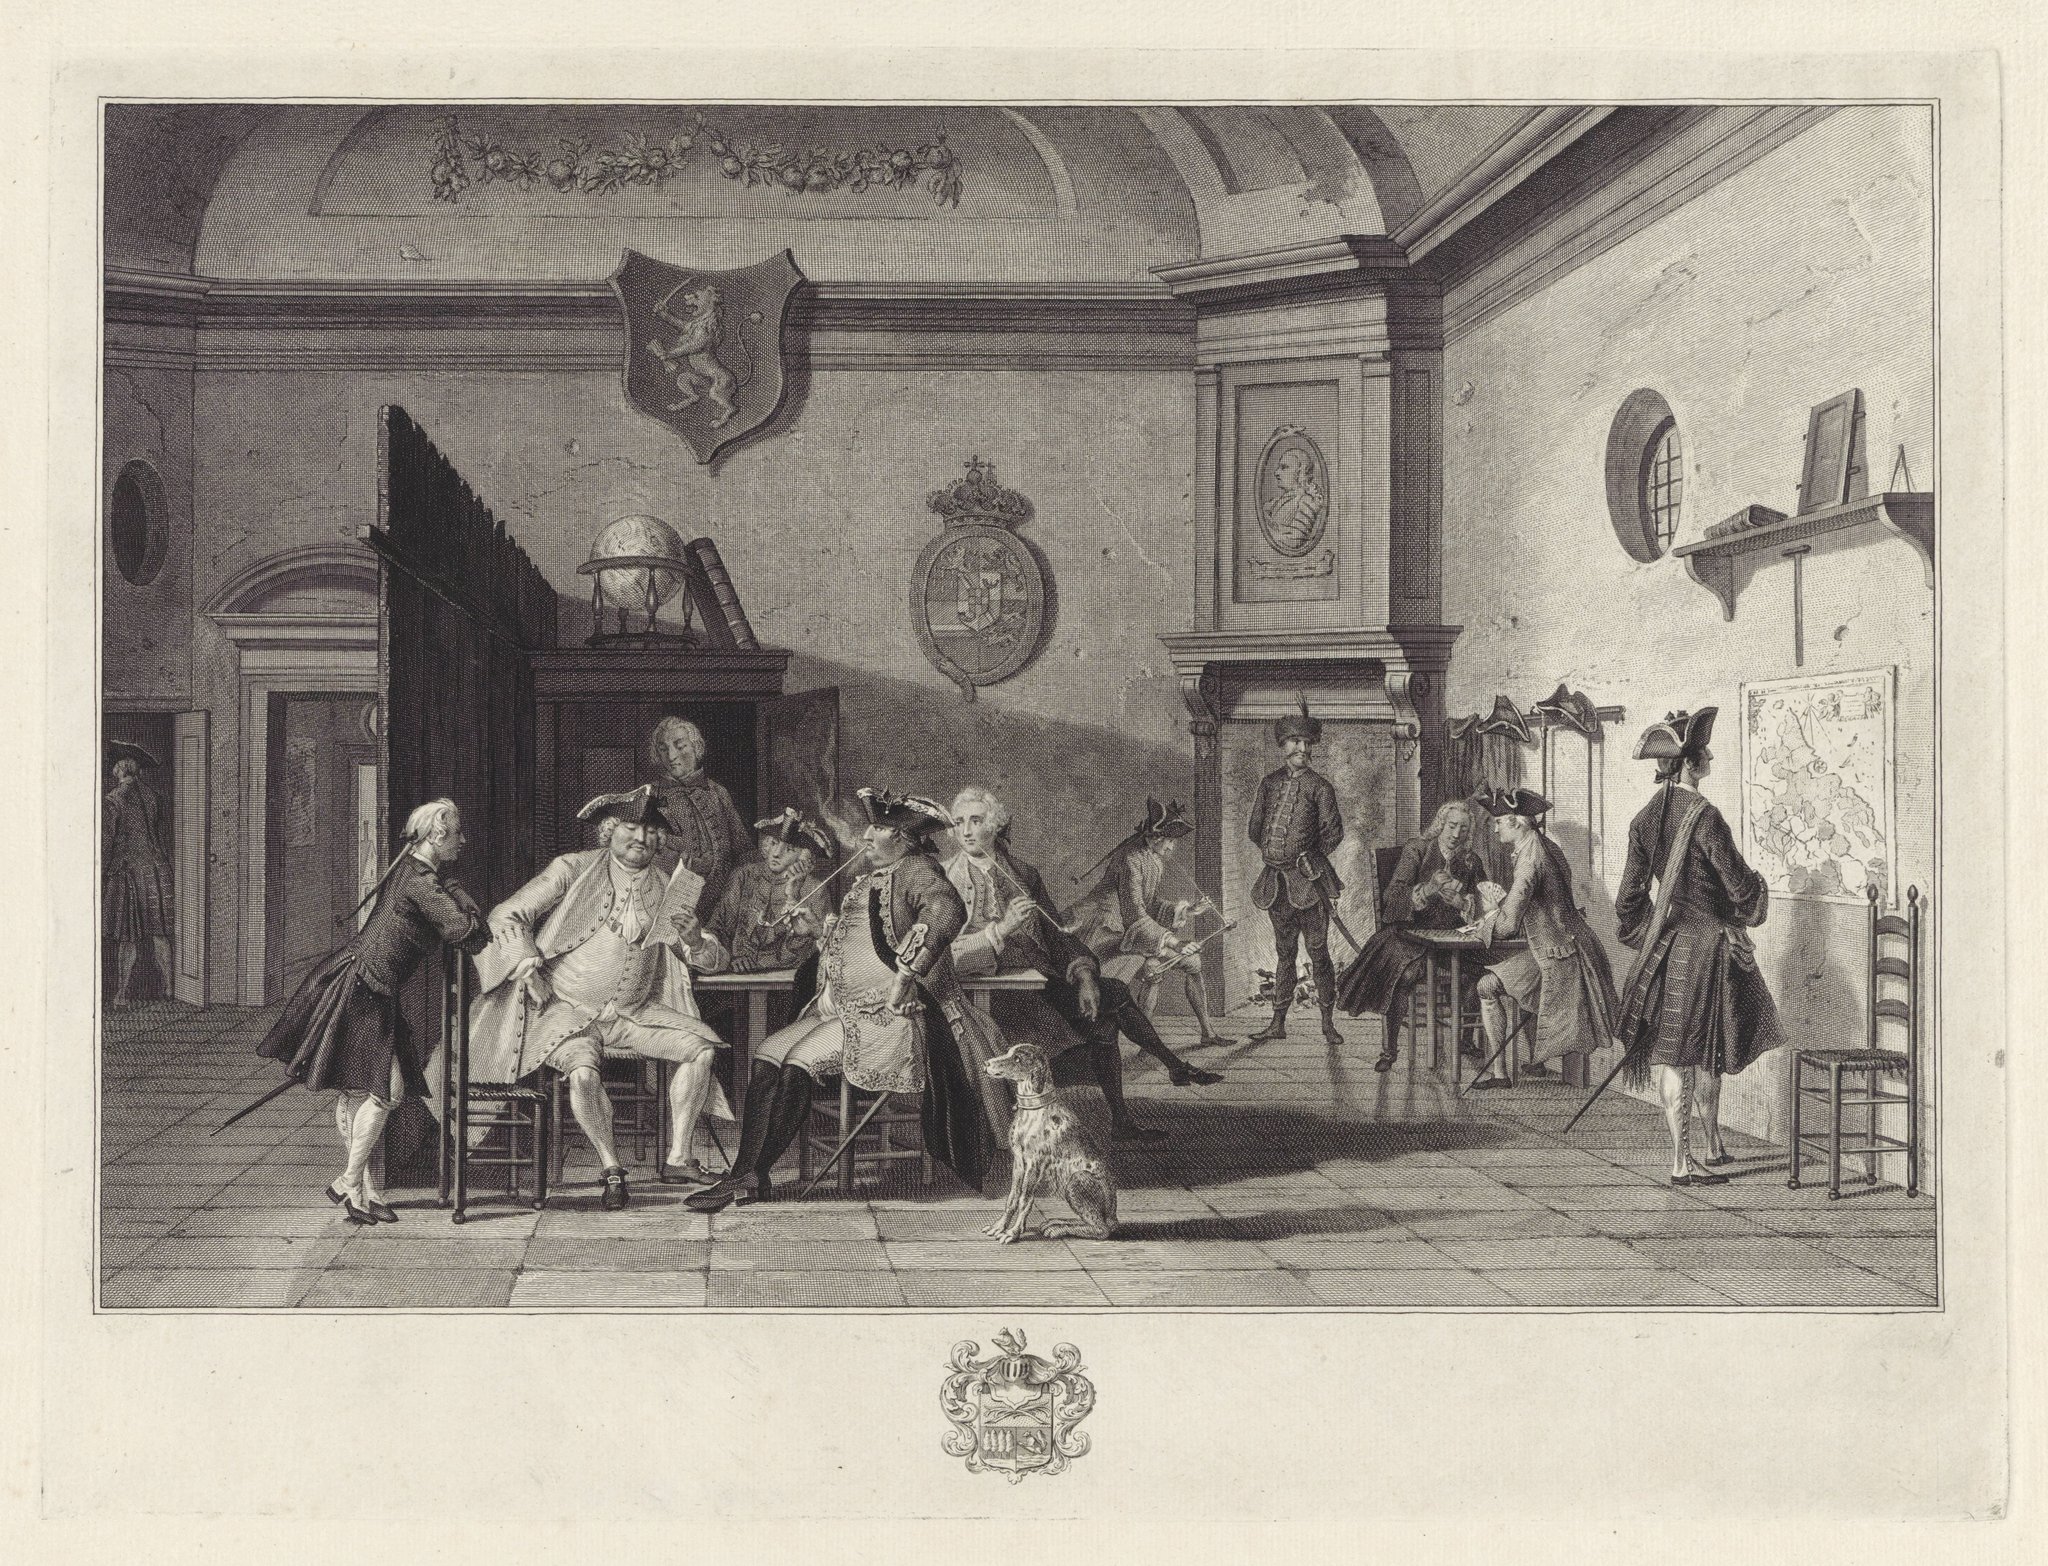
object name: print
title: Wachtlokaal met lezende, rokende en kaartspelende officieren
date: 1754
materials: paper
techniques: engraving, etching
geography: amsterdam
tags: maps of separate countries or regions, in the guard-room, 'kortegaard', officer, dog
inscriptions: collector's mark: Lugt 240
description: Wachtlokaal met lezende, rokende en kaartspelende officieren. Rechts bestudeert een van hen een kaart van de Nederlanden. Aan de muur een wapenschild met de Hollandse Leeuw. Onderaan in de marge het wapenschild van Gerrit Braamcamp, die het originele schilderij in zijn verzameling had.